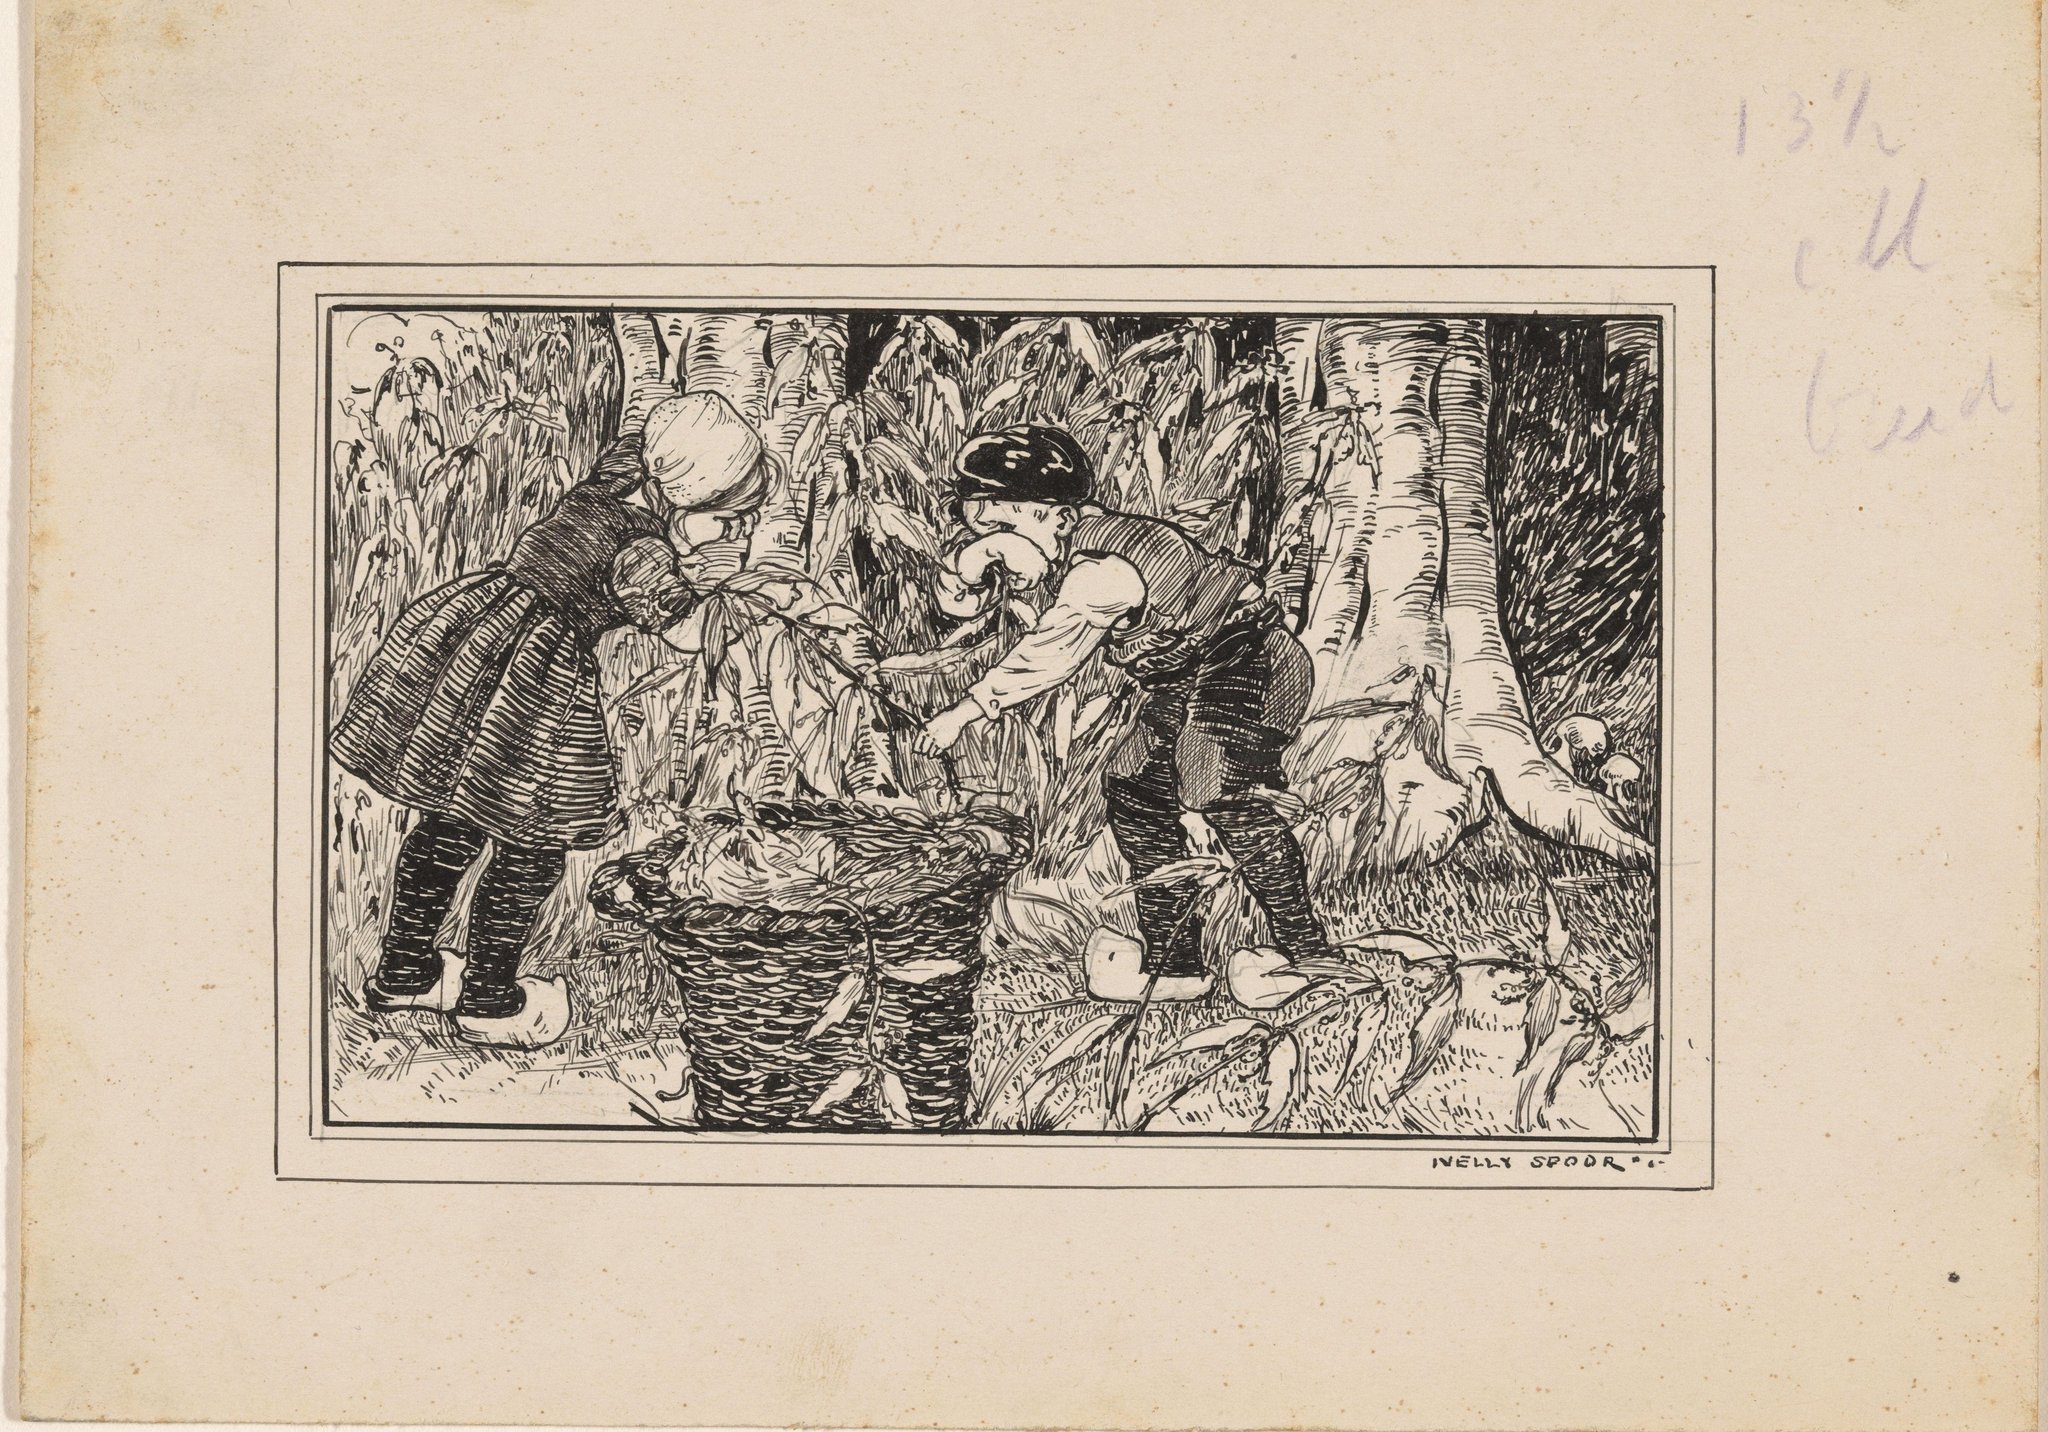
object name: drawing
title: Jongen en meisje verzamelen takken en bladeren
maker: nelly spoor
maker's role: draughtsman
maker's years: 1885-1950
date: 1895-1950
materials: cardboard, ink, pencil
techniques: pen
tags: boy (child between toddler and youth), trees (+ stem, trunk), container made of plant material other than wood: basket, girl (child between toddler and youth)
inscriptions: collector's mark: Lugt 2228, :, signature: ‘NELLY SPOOR ''’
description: Een jongen en meisje staan bij twee boomstammen, mogelijk aan een bosrand, en rapen takken en bladeren. Naast hen staat een mand vol met bladeren. Verso een studie in zwarte pen.